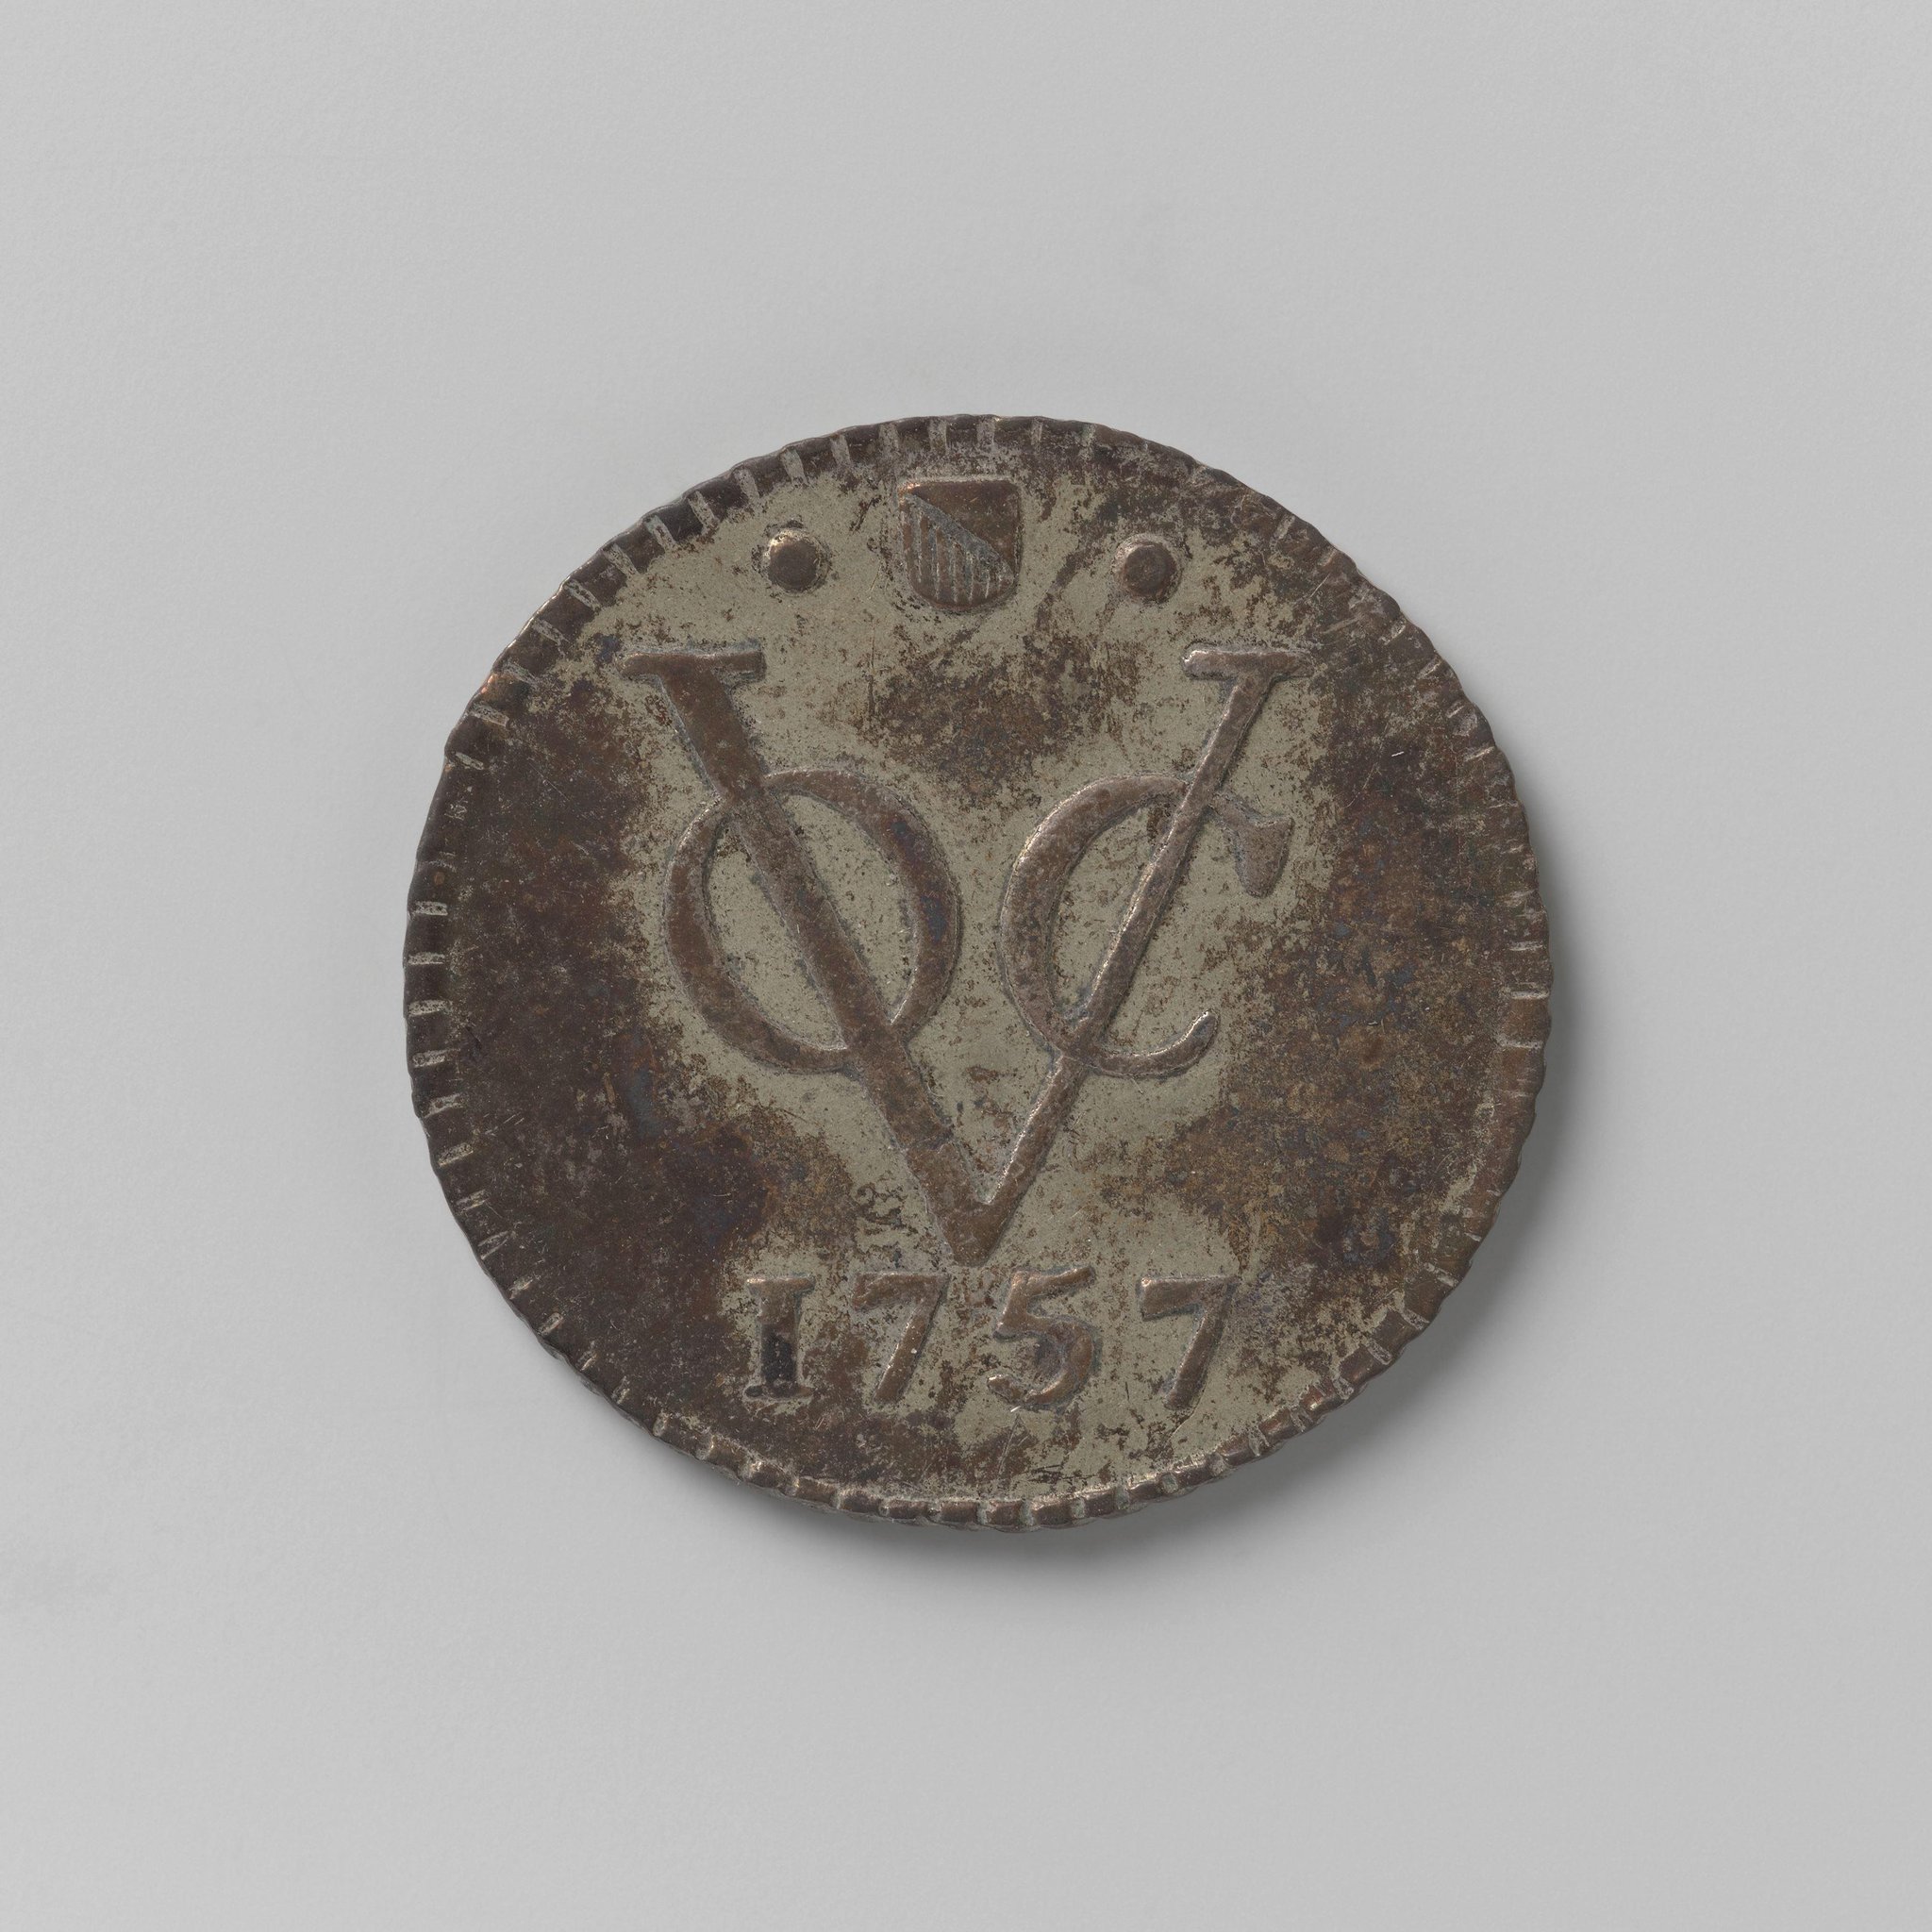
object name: coin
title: VOC, ½ duit stad Utrecht,1757. Afslag in zilver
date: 1757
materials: silver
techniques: striking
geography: utrecht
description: Zilveren munt. Voorzijde: gekroond ingebogen wapenschild van de stad Utrecht. Keerzijde: monogram van de VOC, waarboven muntteken en waaronder jaartal. Kabelrand.